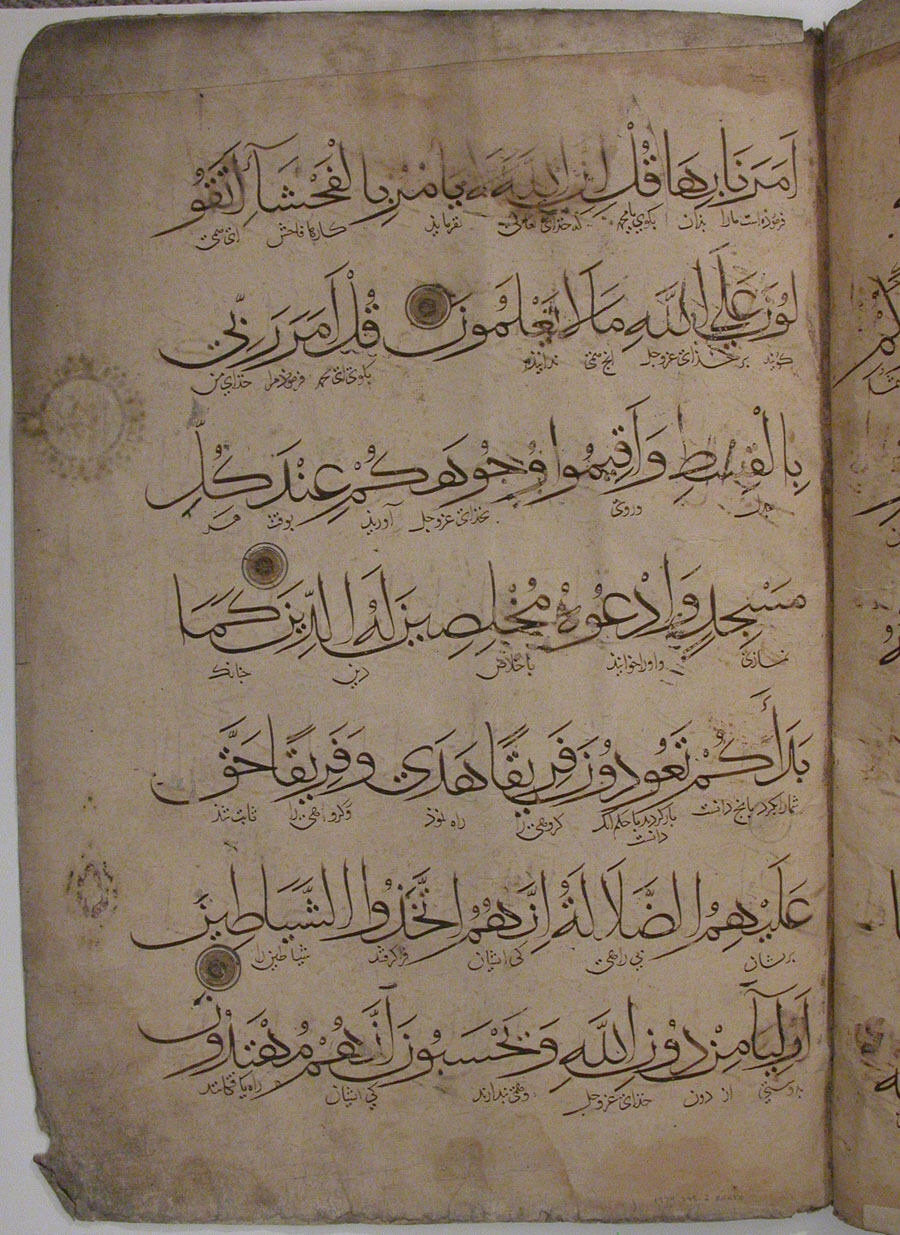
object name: folio from a non illustrated manuscript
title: Folio from a Qur'an Manuscript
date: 1301-1400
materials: gold, ink, paper, watercolor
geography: india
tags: qur'an,calligraphy